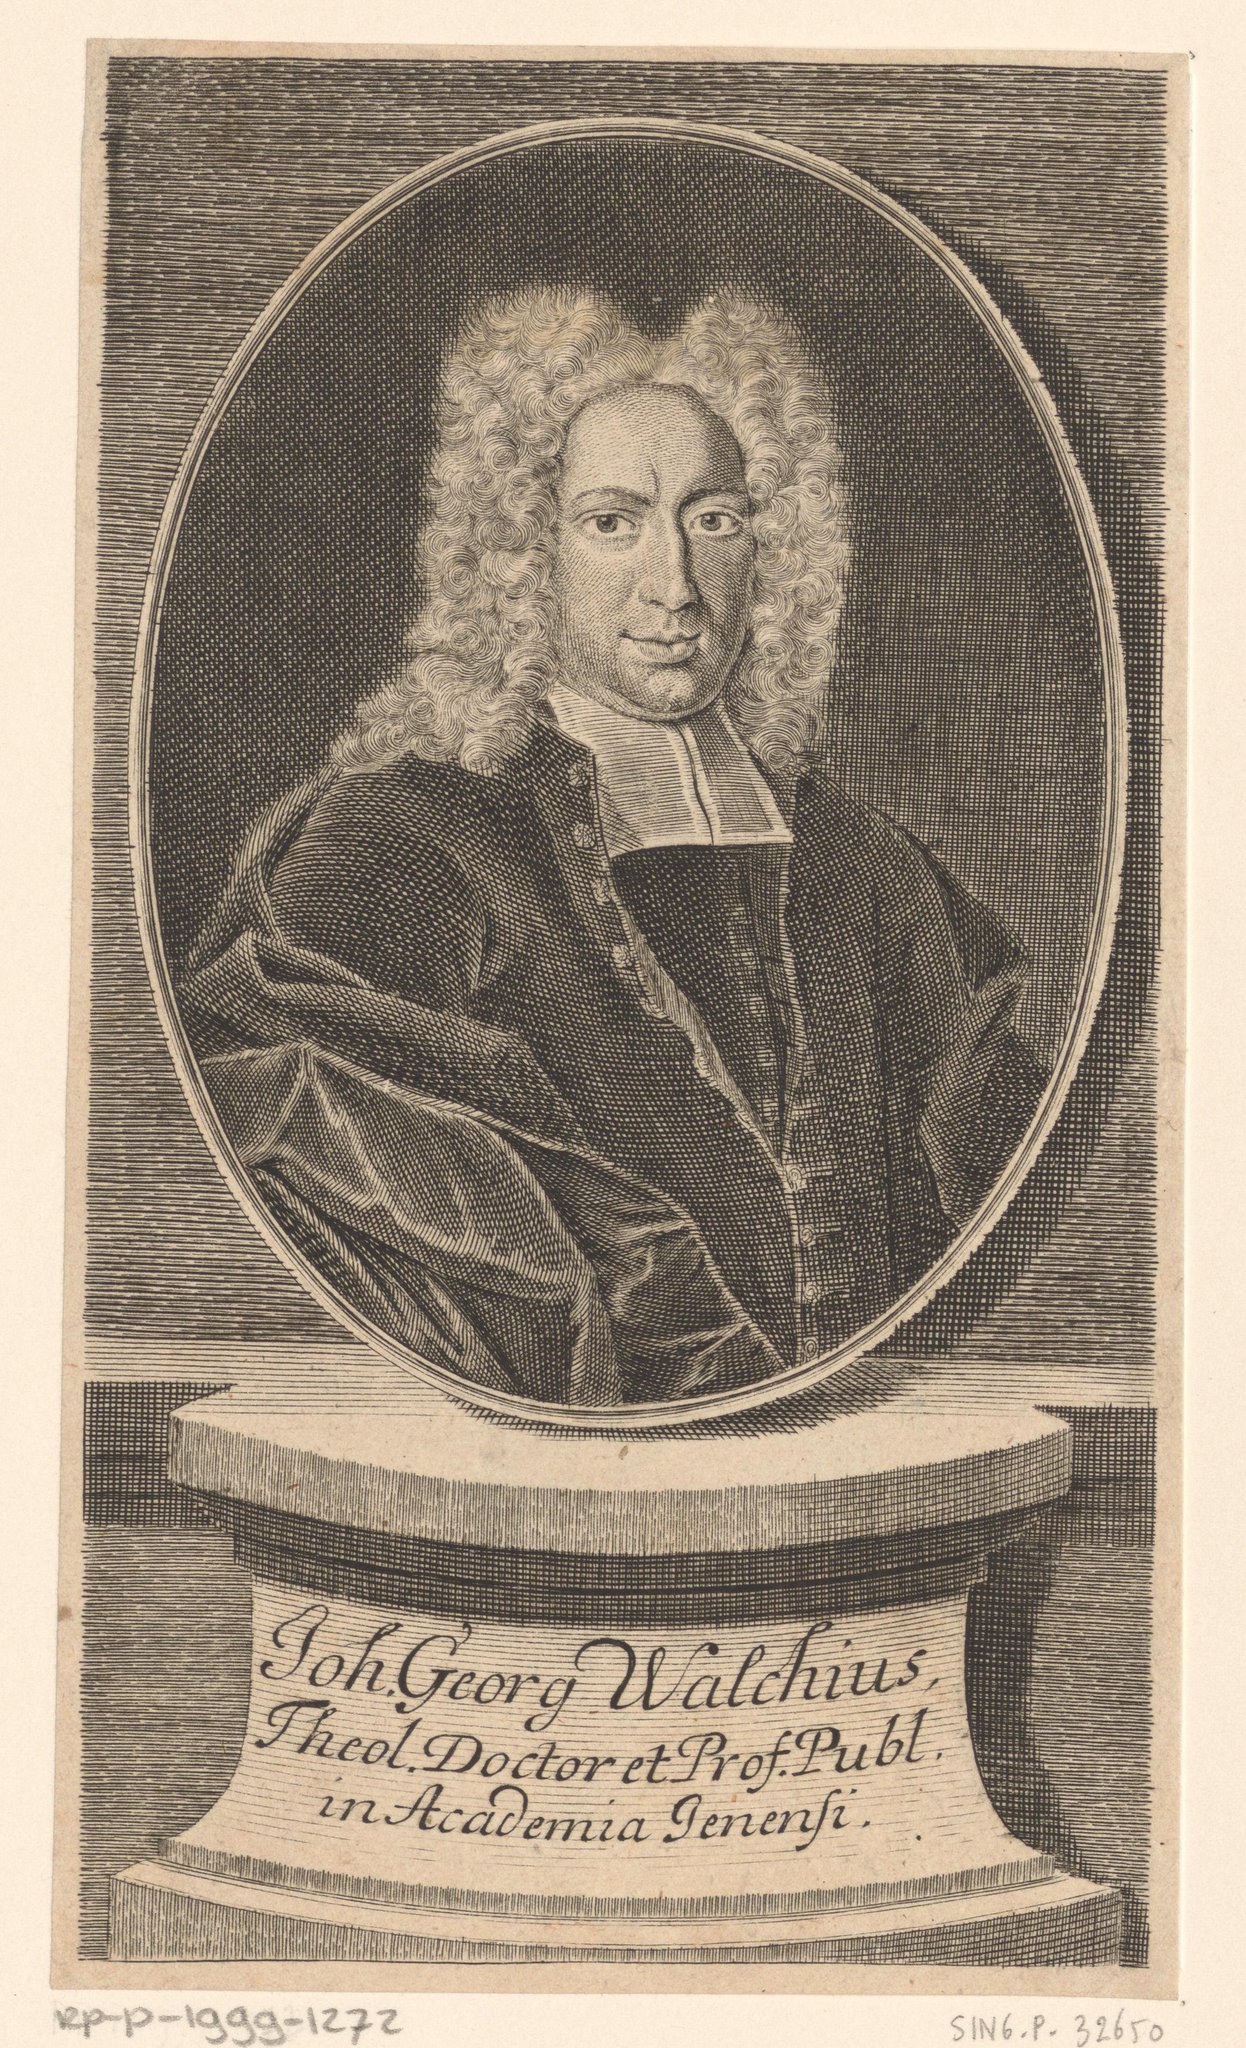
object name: print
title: Portret van Johann Georg Walch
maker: martin bernigeroth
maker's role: print maker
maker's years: 1670-1733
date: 1716-1733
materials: paper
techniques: engraving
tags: theologian, historical persons, professor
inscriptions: collector's mark: Lugt 2760, collector's mark: Lugt 2228